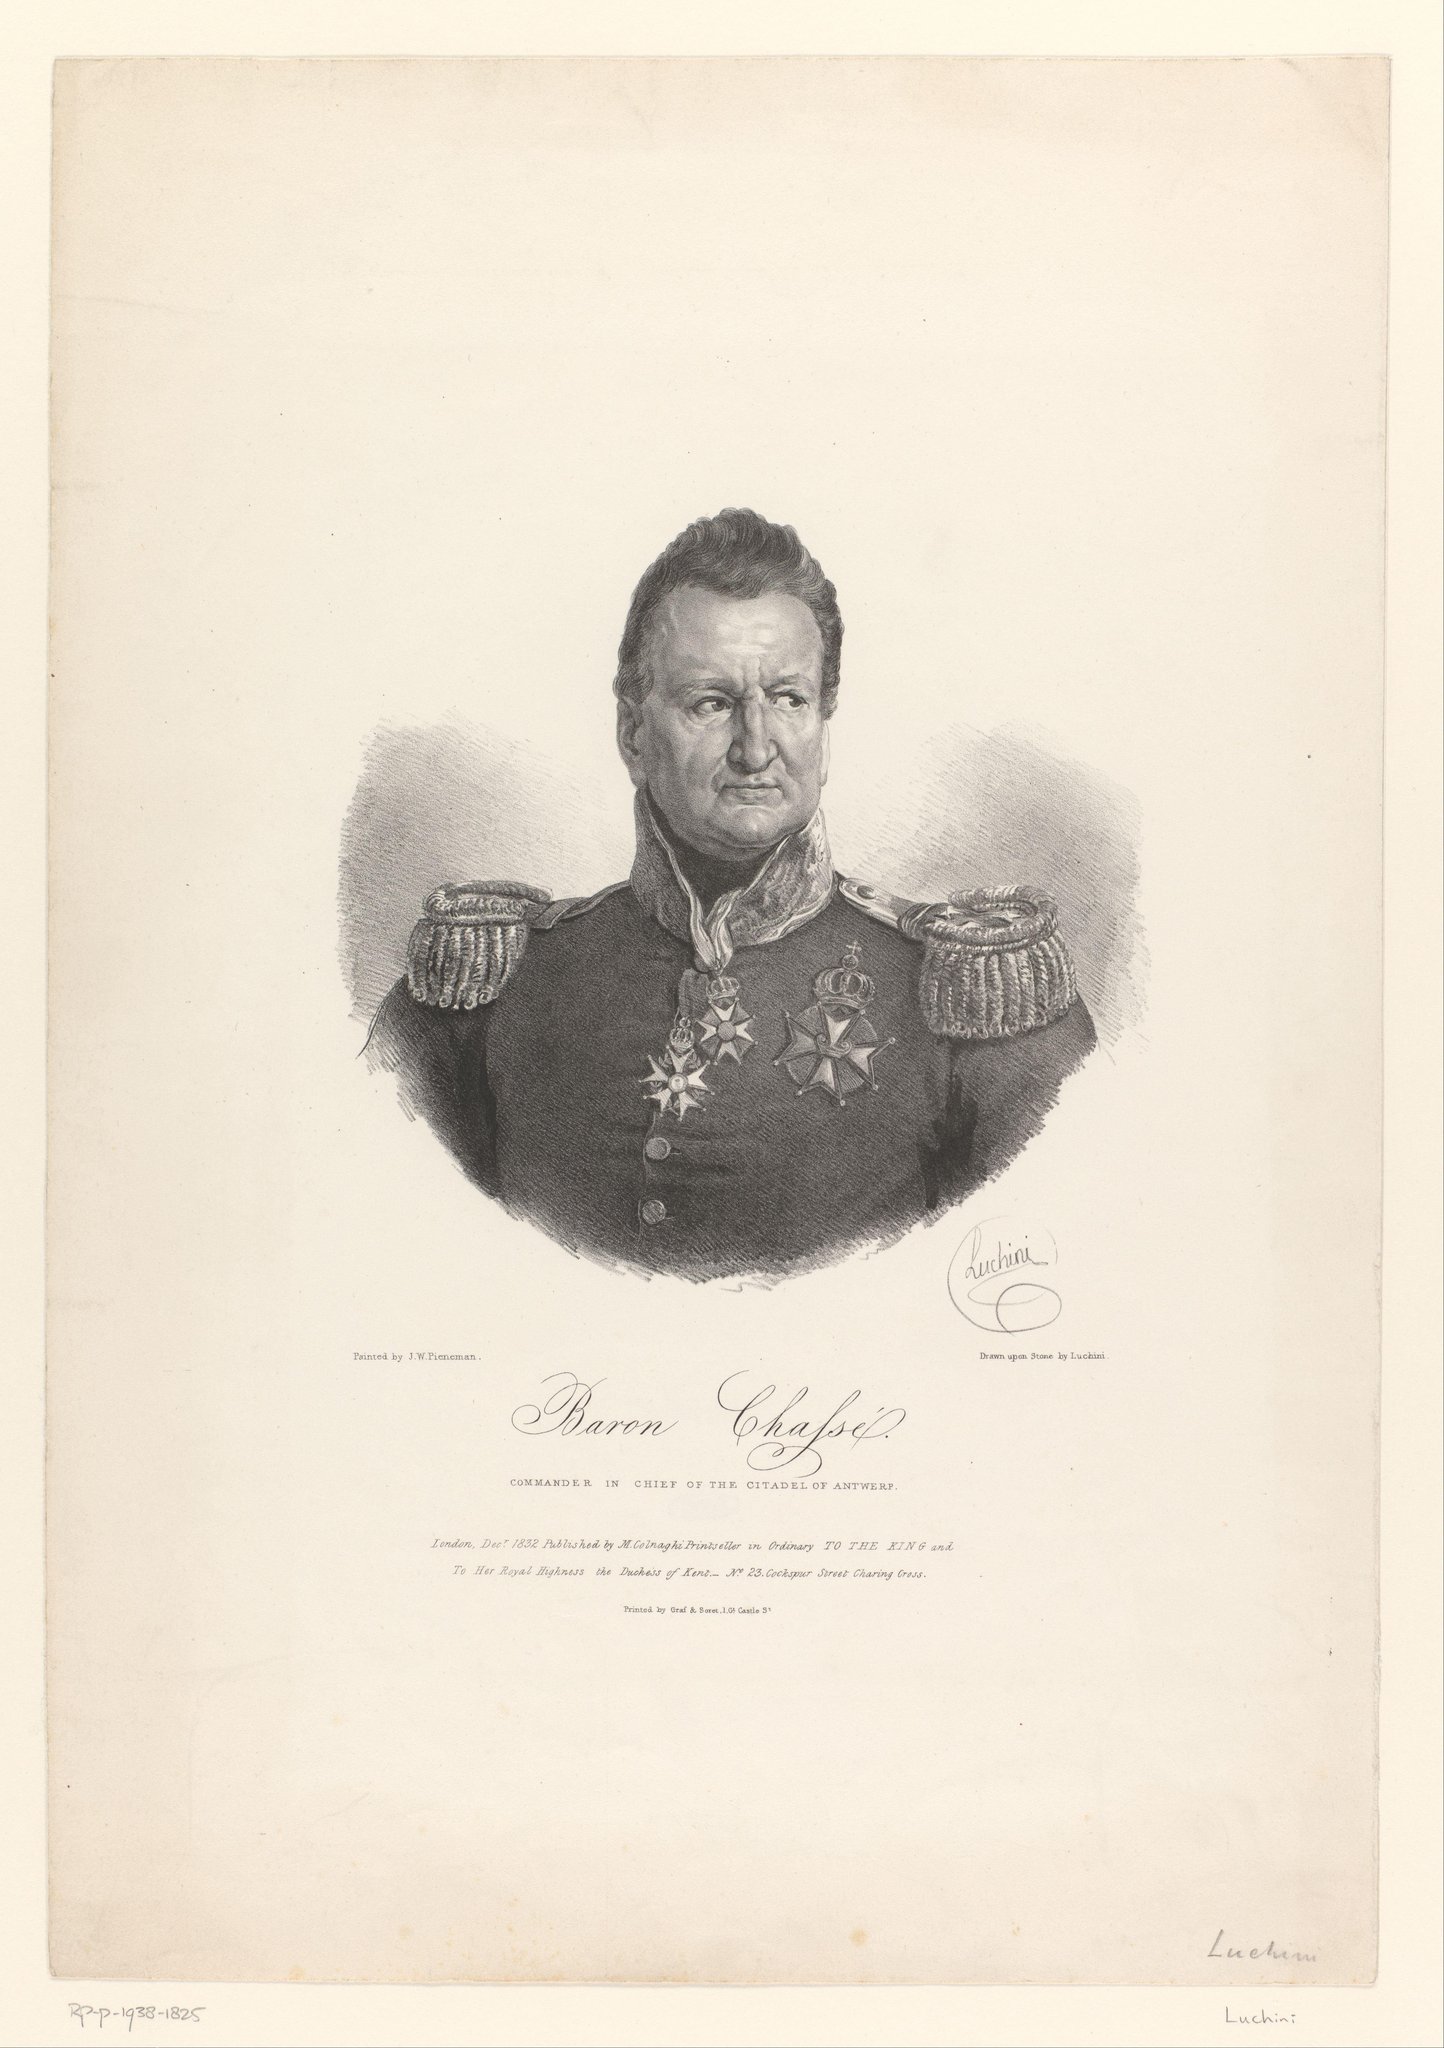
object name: print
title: Portret van baron David Hendrik Chassé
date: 1832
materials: paper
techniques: lithograph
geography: italy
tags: david hendrik baron chassé, historical persons, ruler, sovereign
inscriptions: collector's mark: Lugt 2228